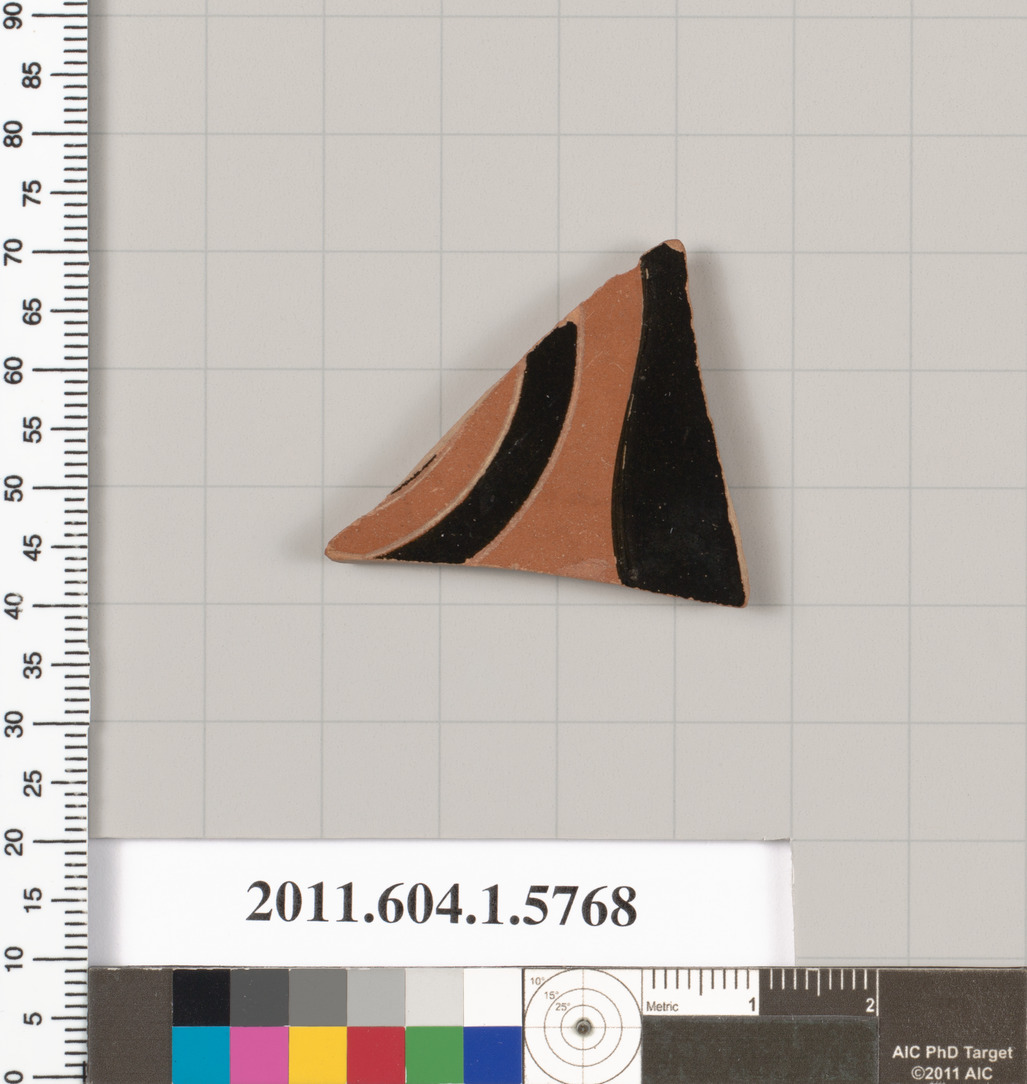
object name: kylix fragment, eye cup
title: Terracotta fragment of a kylix: eye-cup (drinking cup)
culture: greek, attic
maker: oltos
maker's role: artist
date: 520-510 BCE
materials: terracotta